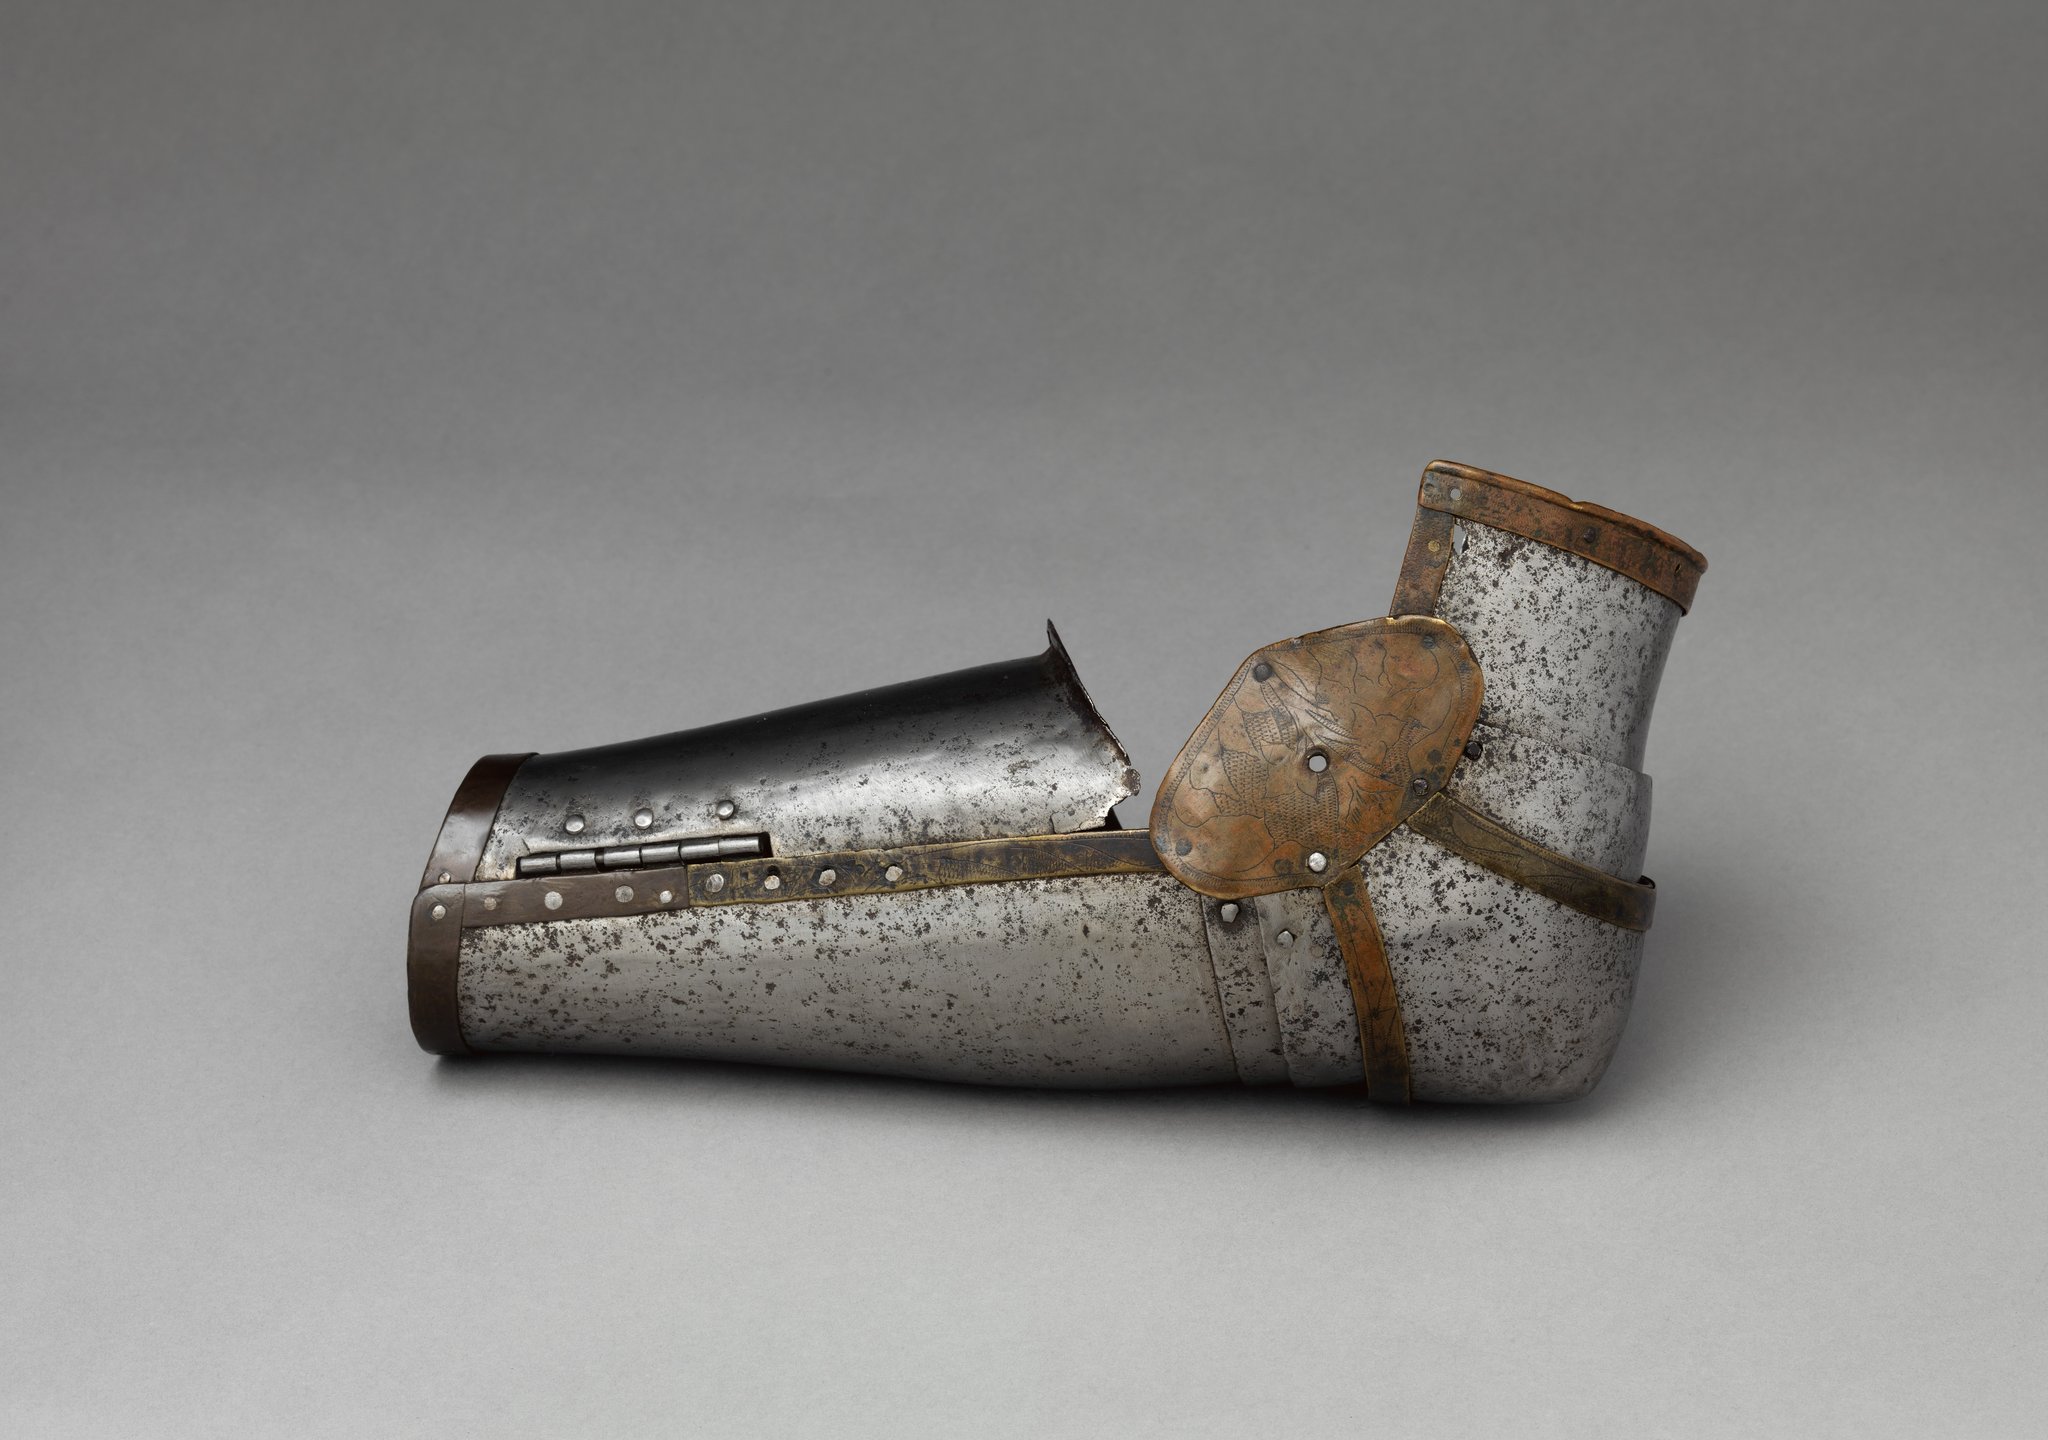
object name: left vambrace arm defense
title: Left Arm Defense (Vambrace)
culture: italian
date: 1380-1400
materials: copper alloy, steel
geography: italy